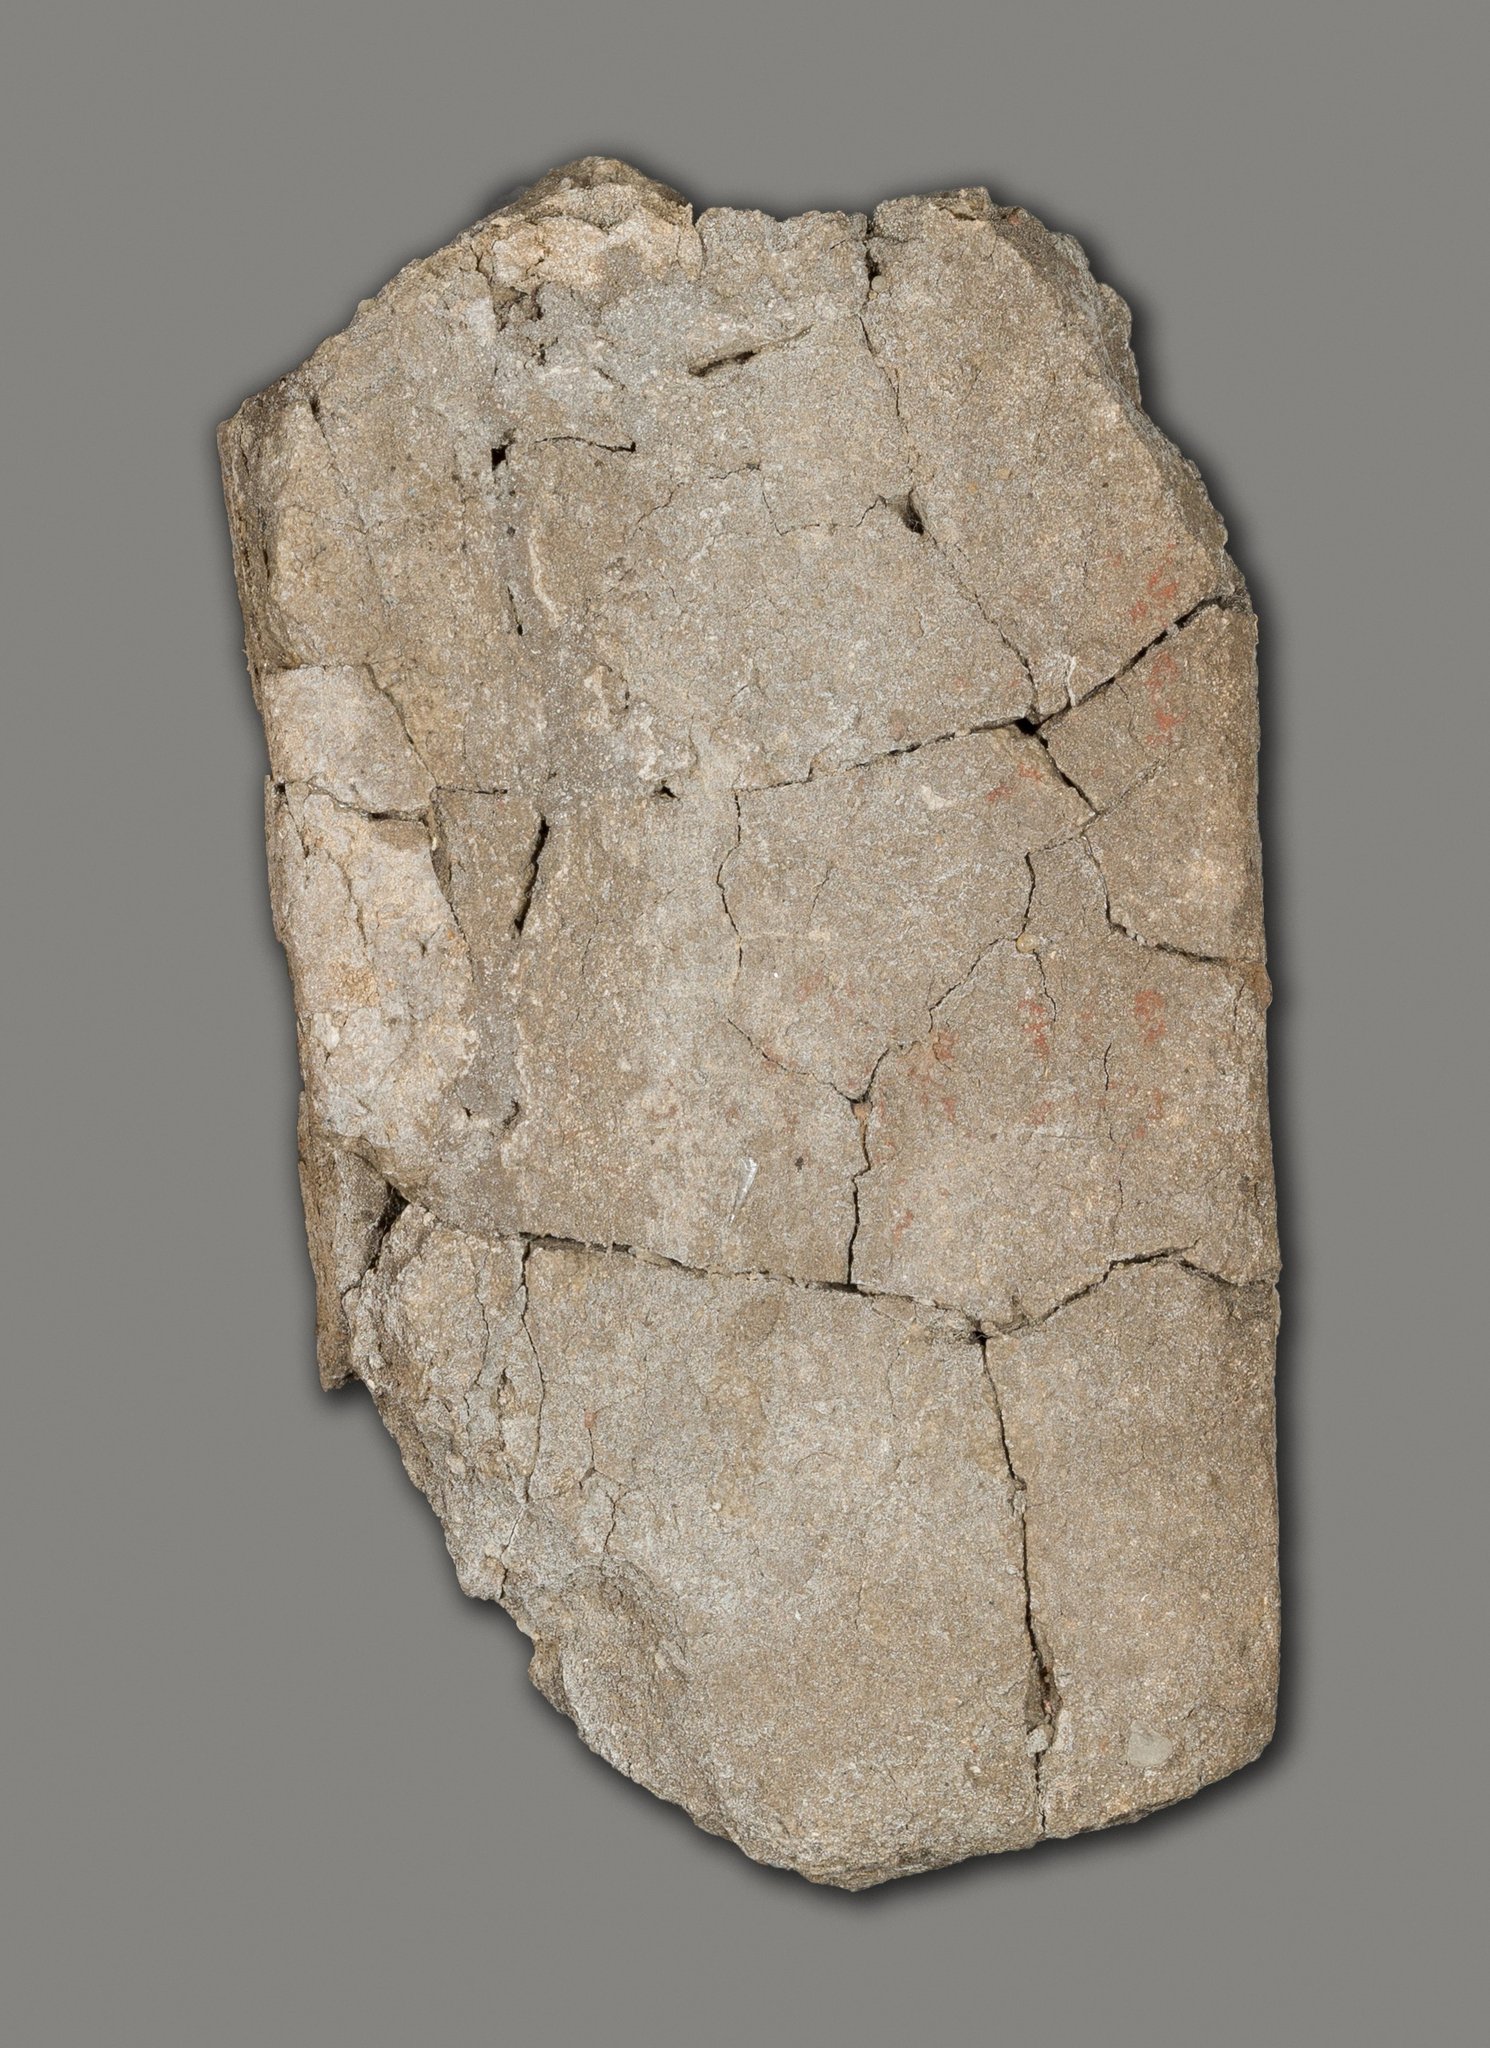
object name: figure, magical, execration, tablet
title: Magical Figure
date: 1802-1550 BCE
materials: clay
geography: egypt